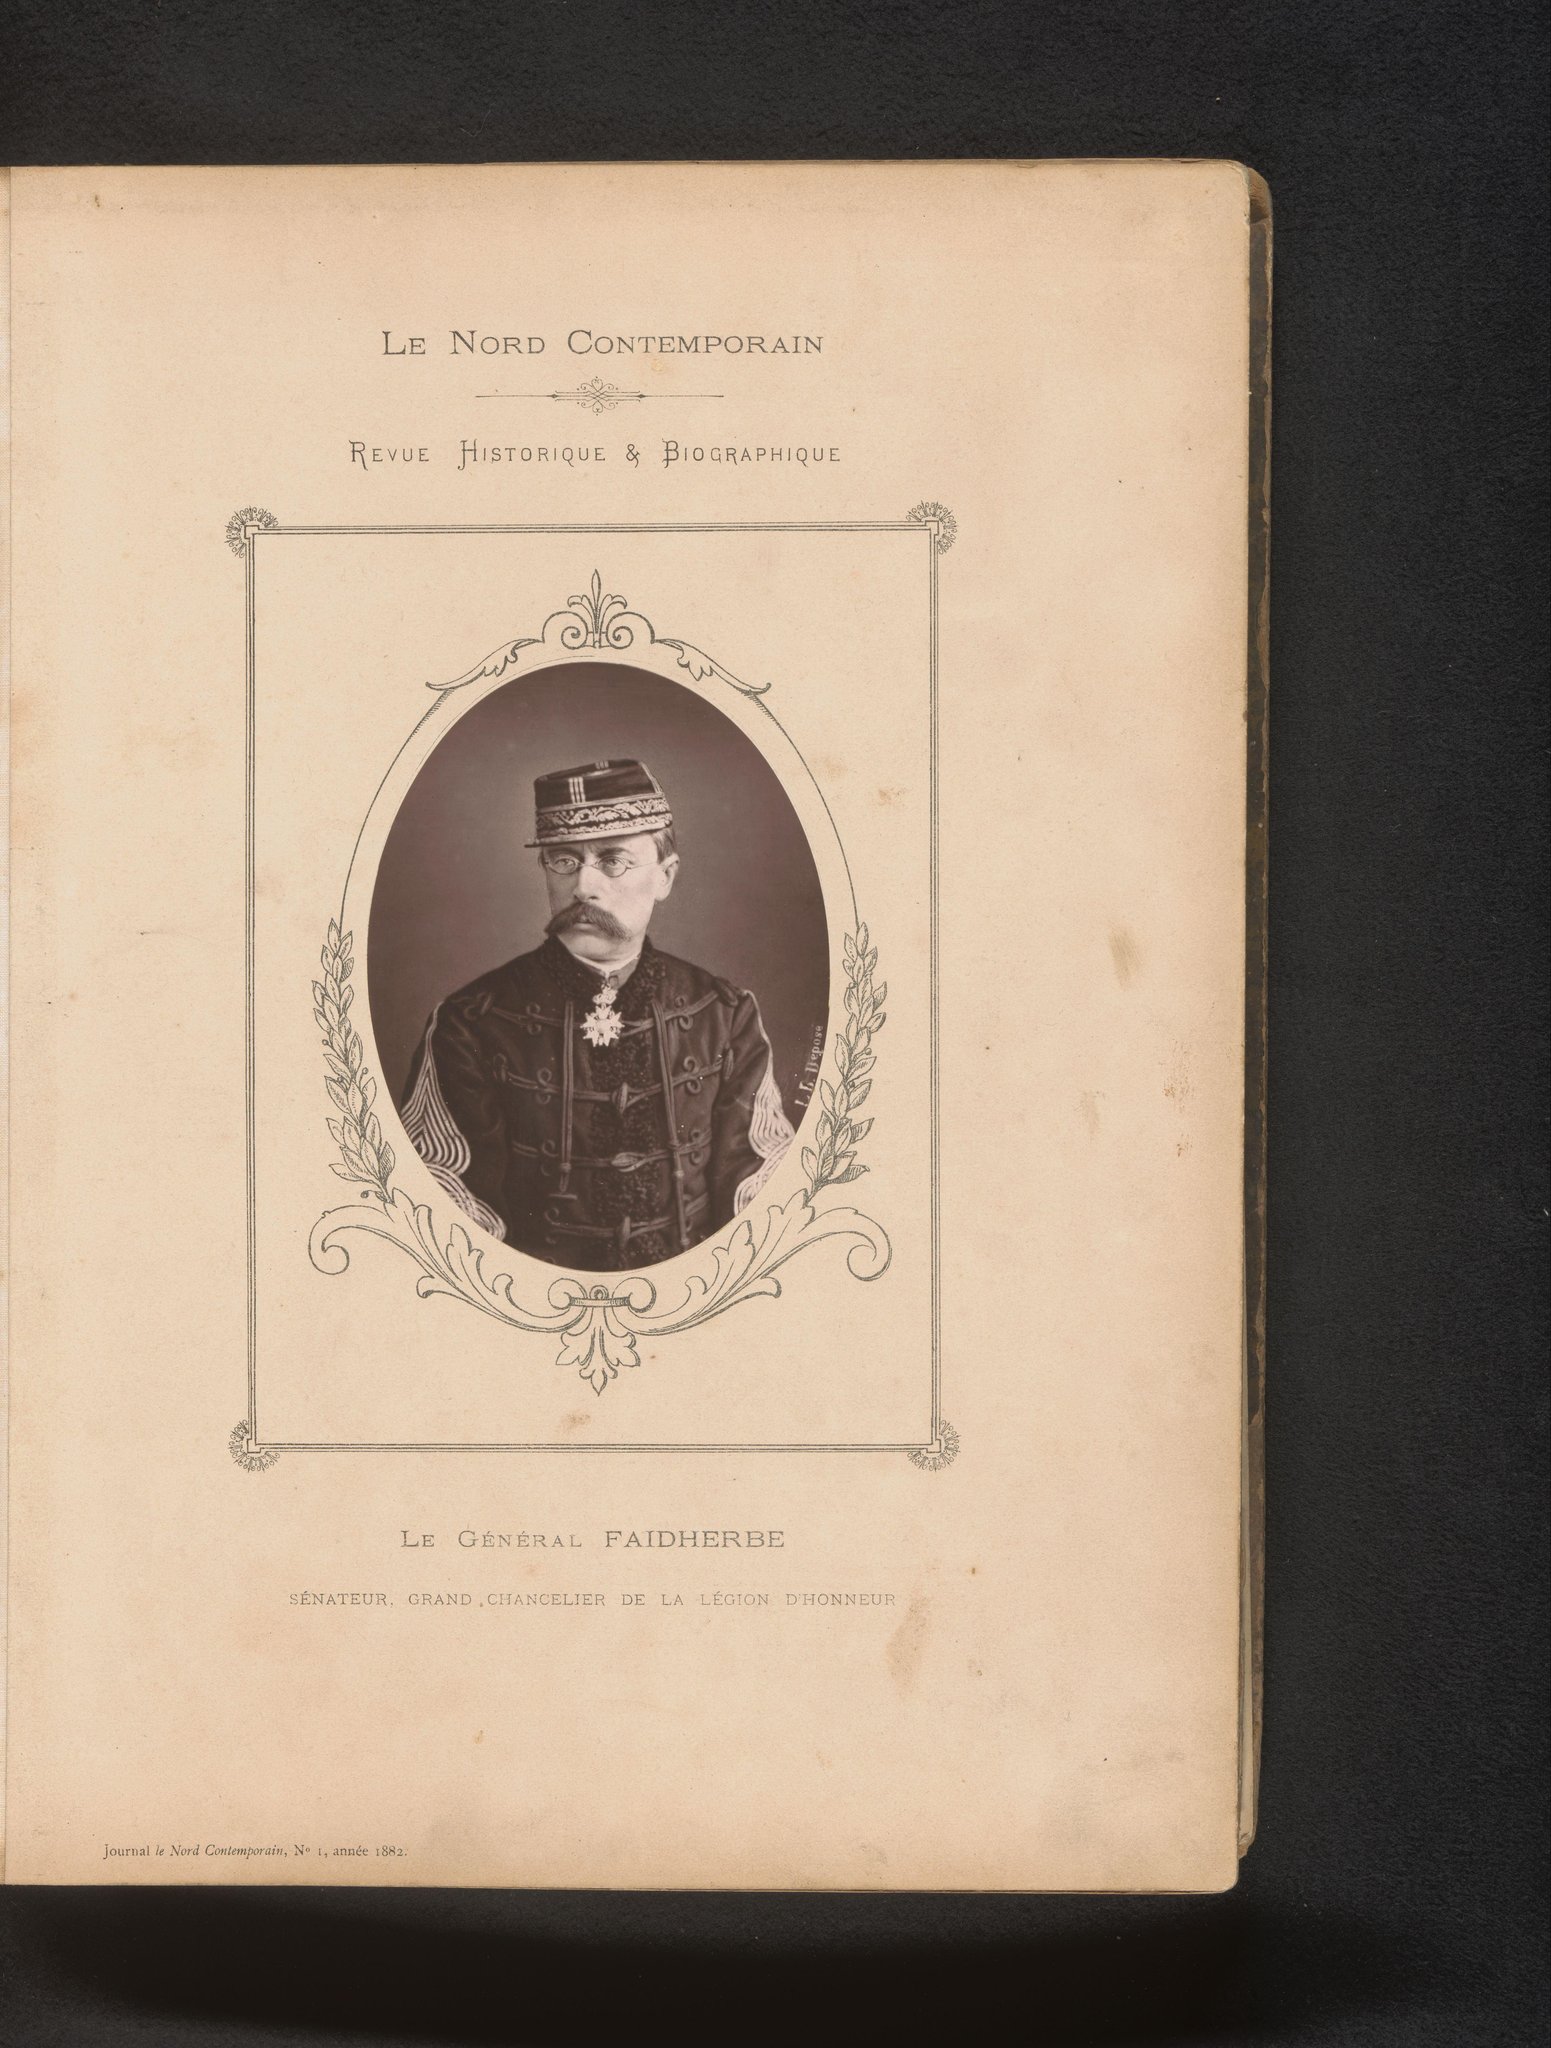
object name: page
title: Le général Faidherbe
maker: Anonymous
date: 1878-1882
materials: paper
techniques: woodburytype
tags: historical persons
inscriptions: inscription: ‘Sénateur, grand chancelier de la légion d'honneur’, inscription: ‘L.B. Depose’, inscription: ‘Le Nord Contemporain/ Revue Historique & Biographique’, inscription: ‘Journal le Nord Contemporain, No 1, année 1882’